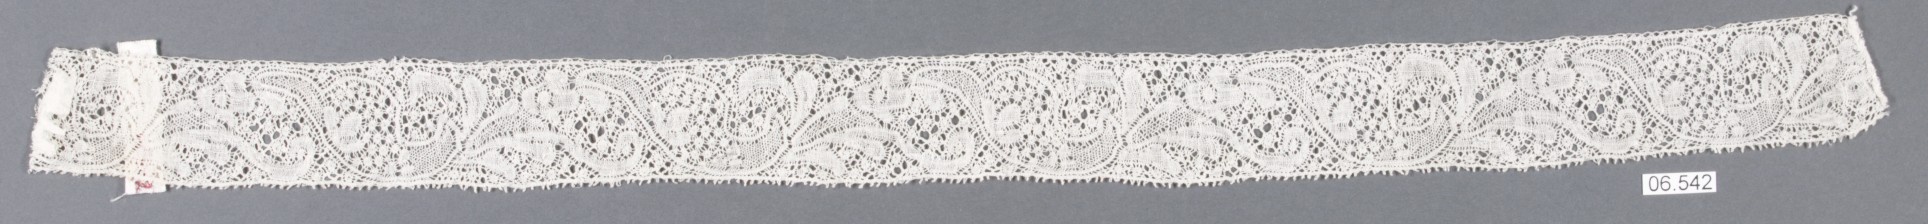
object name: strip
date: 1701-1800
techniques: lace